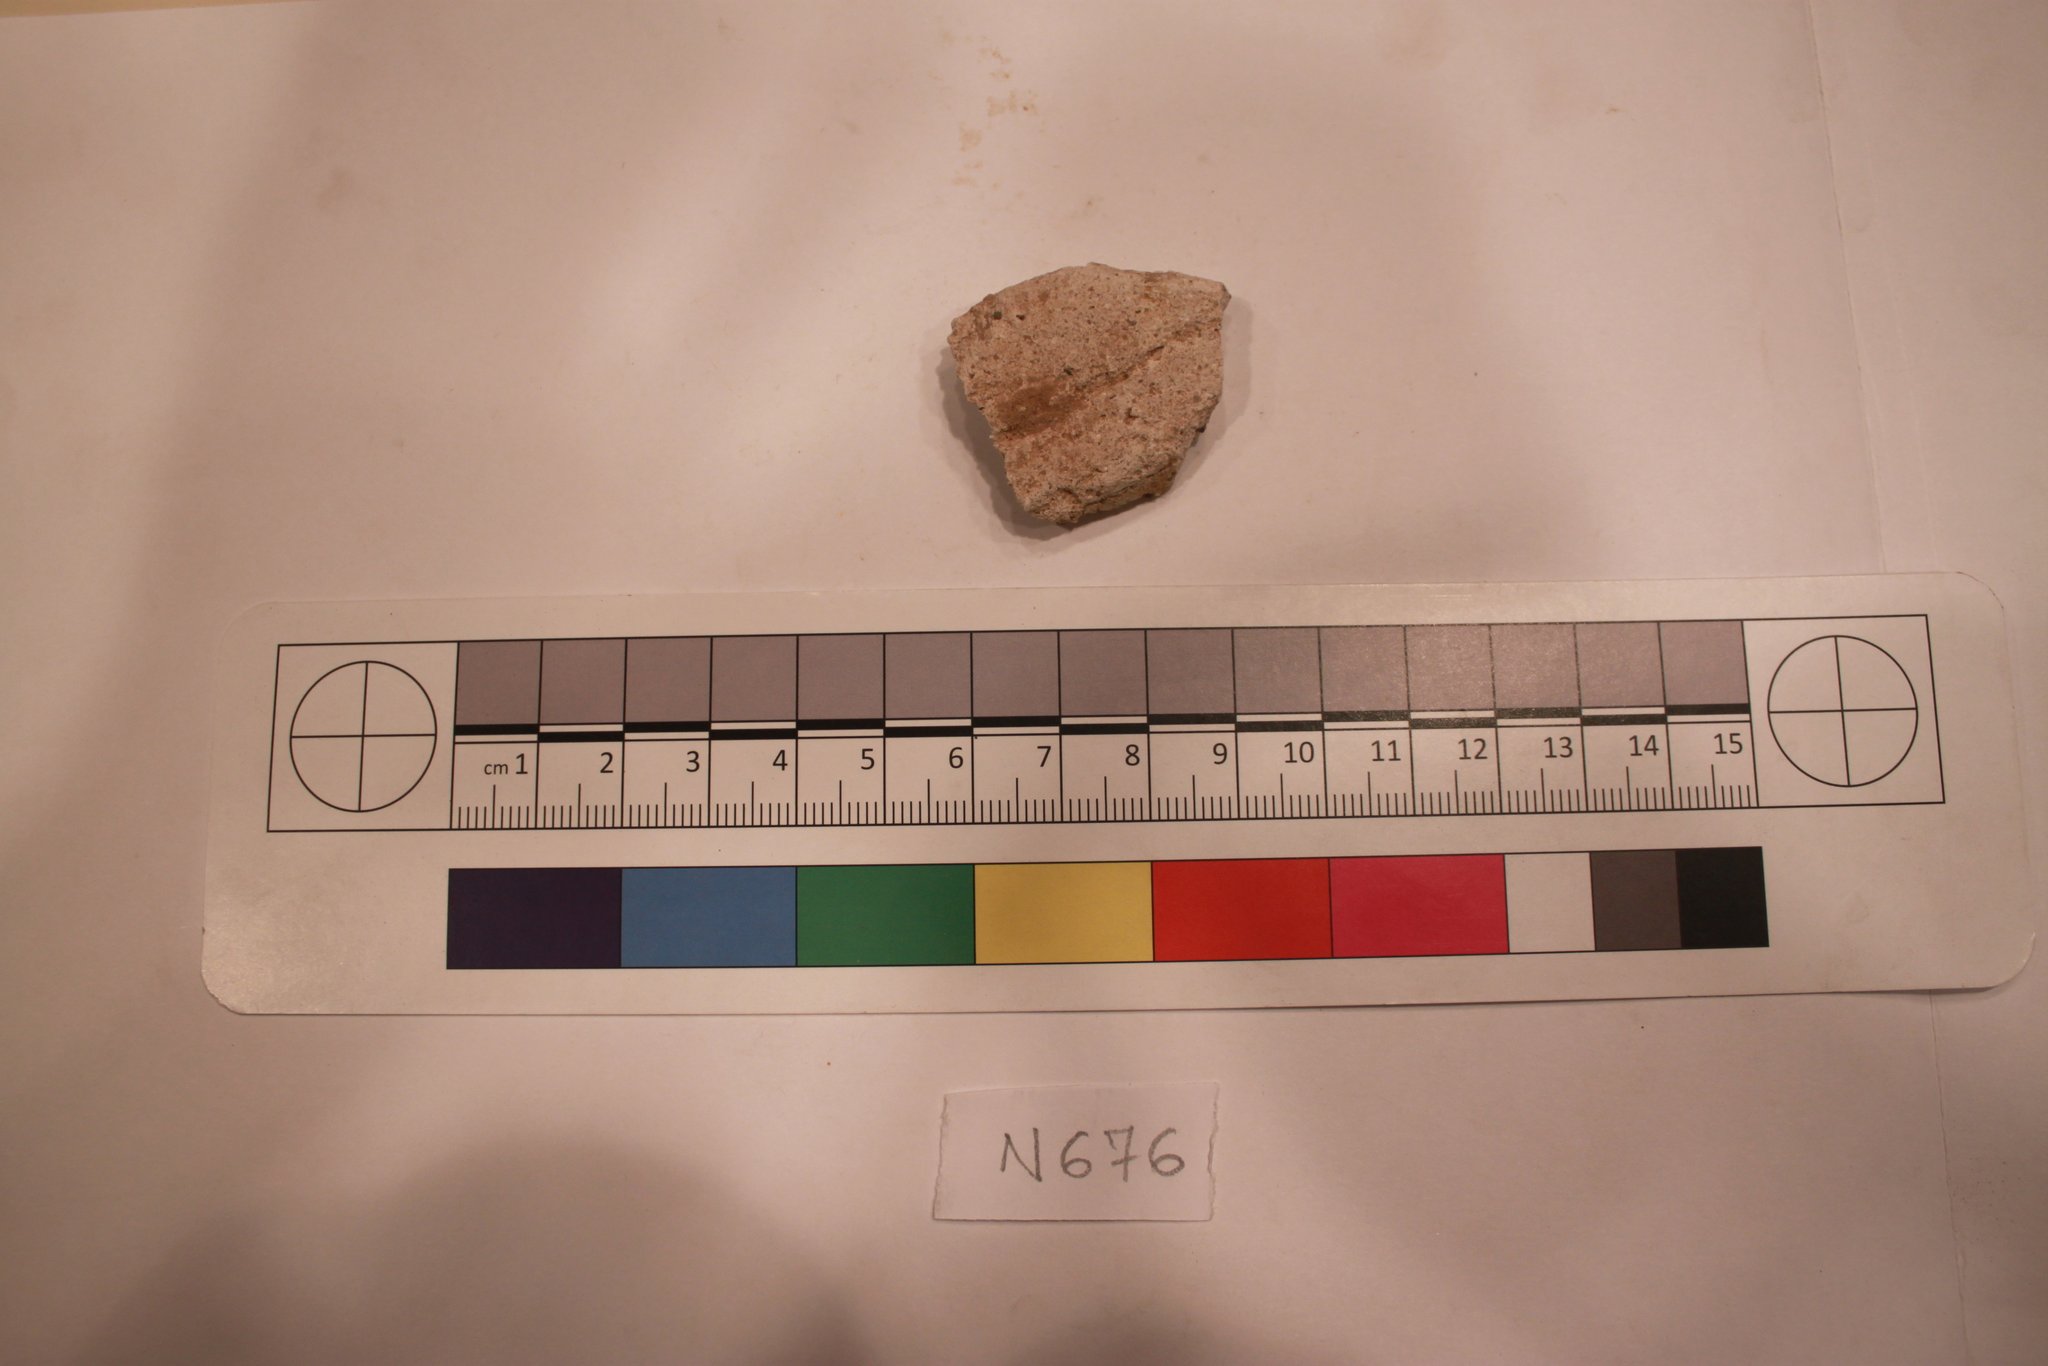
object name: fragment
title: Stucco Fragment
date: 701-1200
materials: plaster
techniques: carving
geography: iran